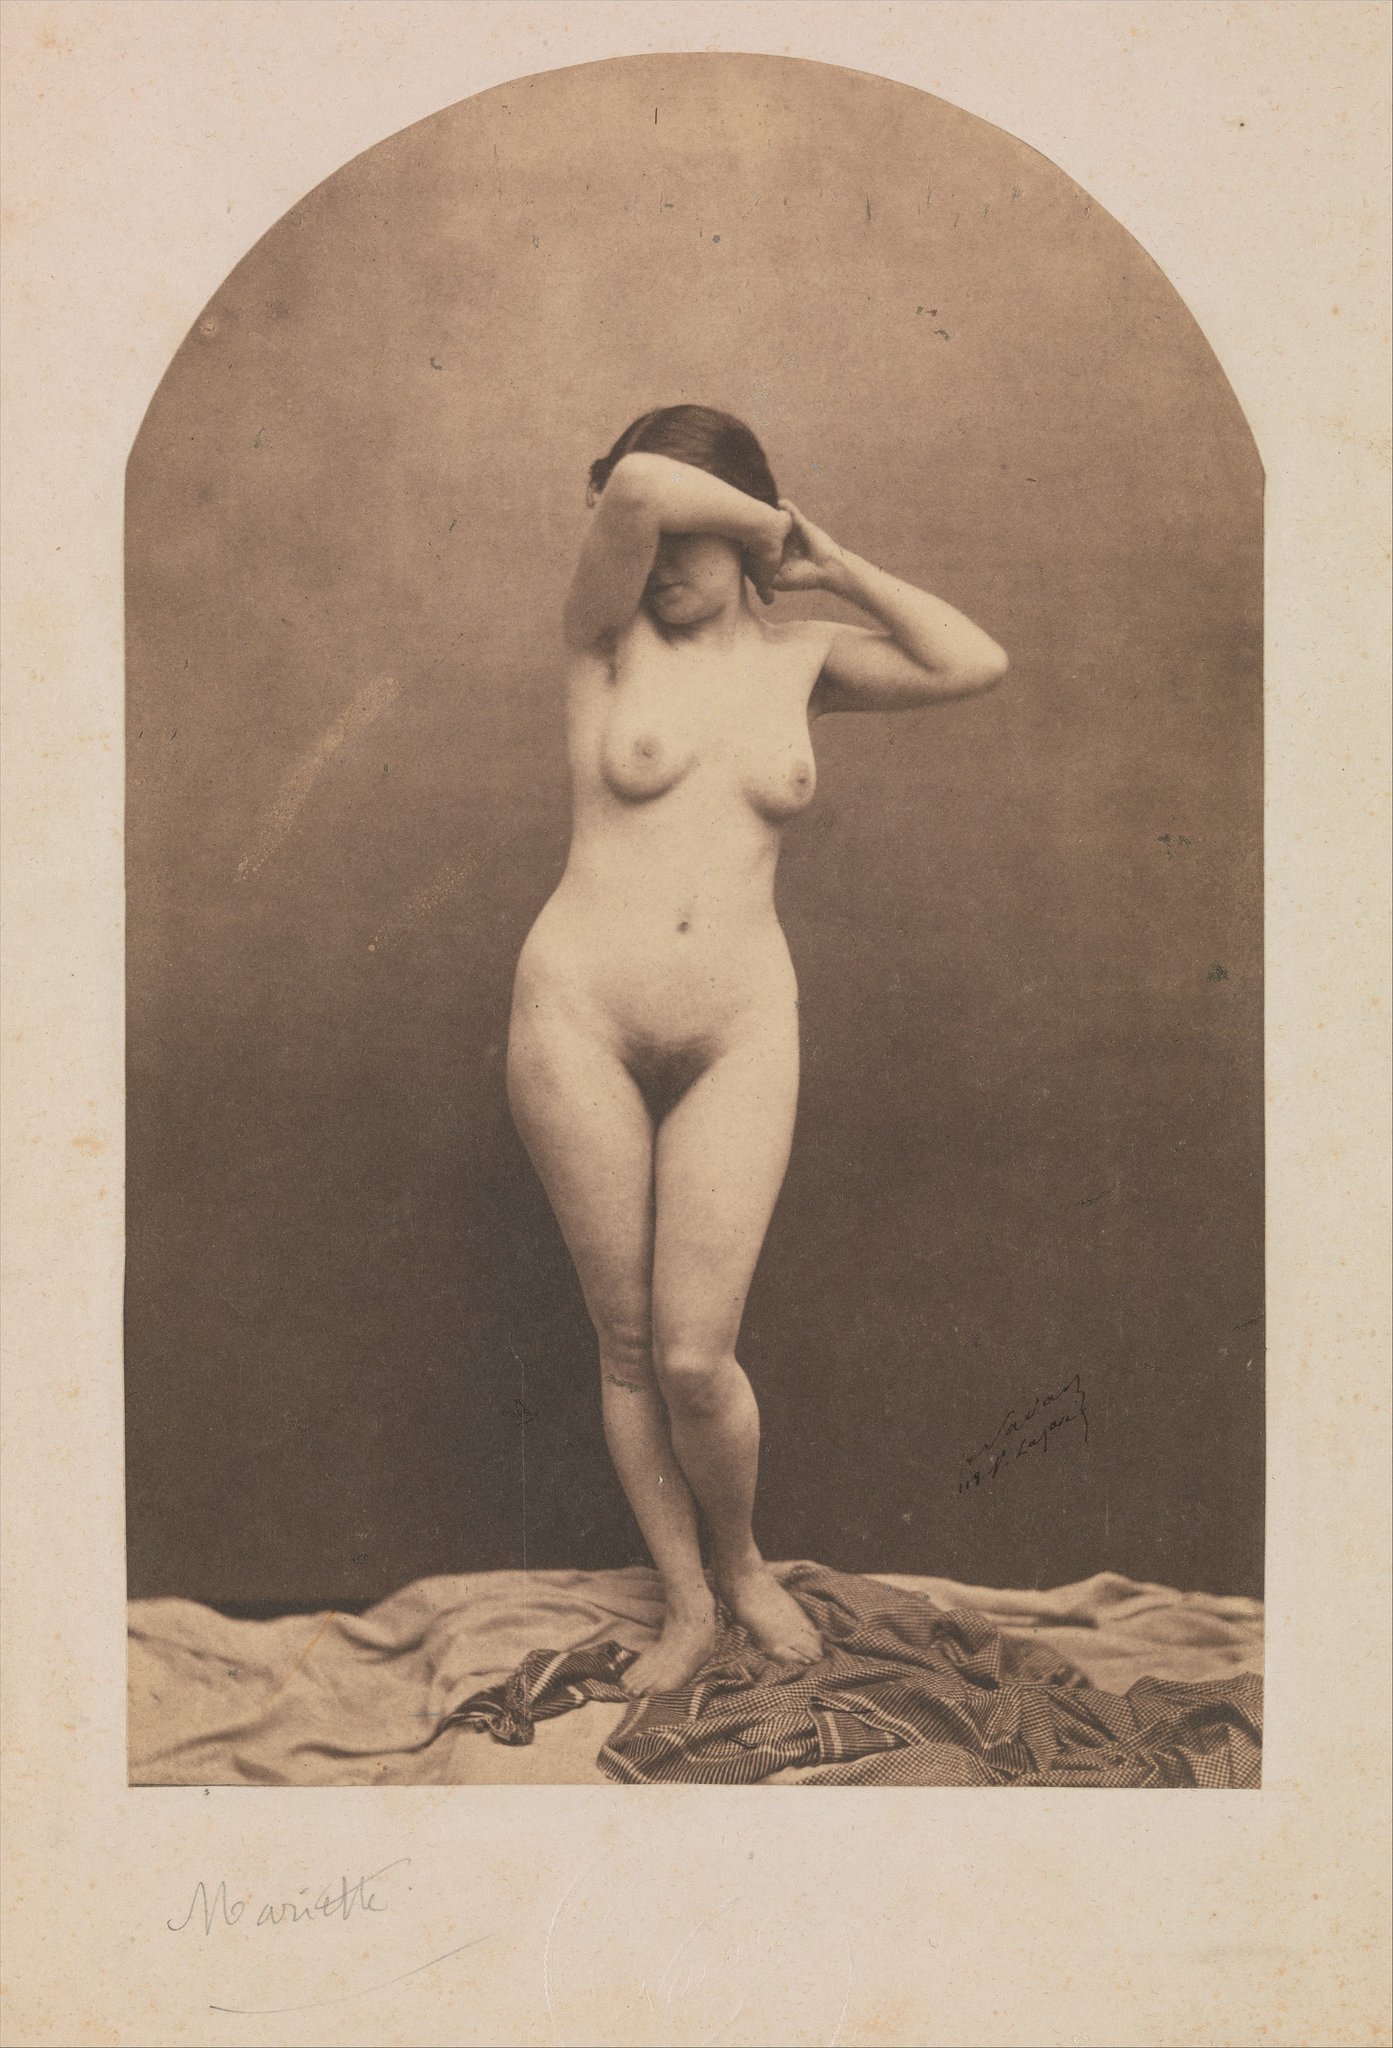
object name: photograph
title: [Standing Female Nude]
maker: félix nadar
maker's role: artist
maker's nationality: french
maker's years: 1820-1910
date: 1860-1861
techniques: glass negative, salted paper print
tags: female nudes